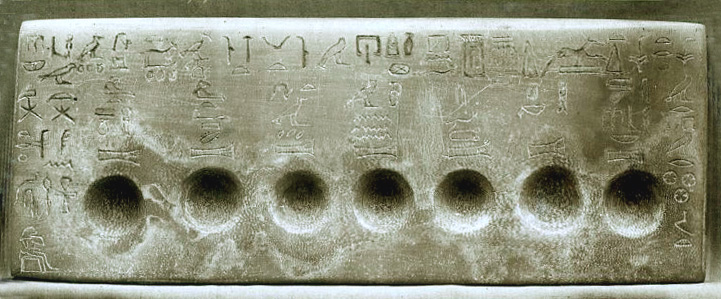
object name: offering slab, seven oil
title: Offering slab for seven oils of Ankhwadjes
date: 2649-2100 BCE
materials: stone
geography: egypt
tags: hieroglyphs